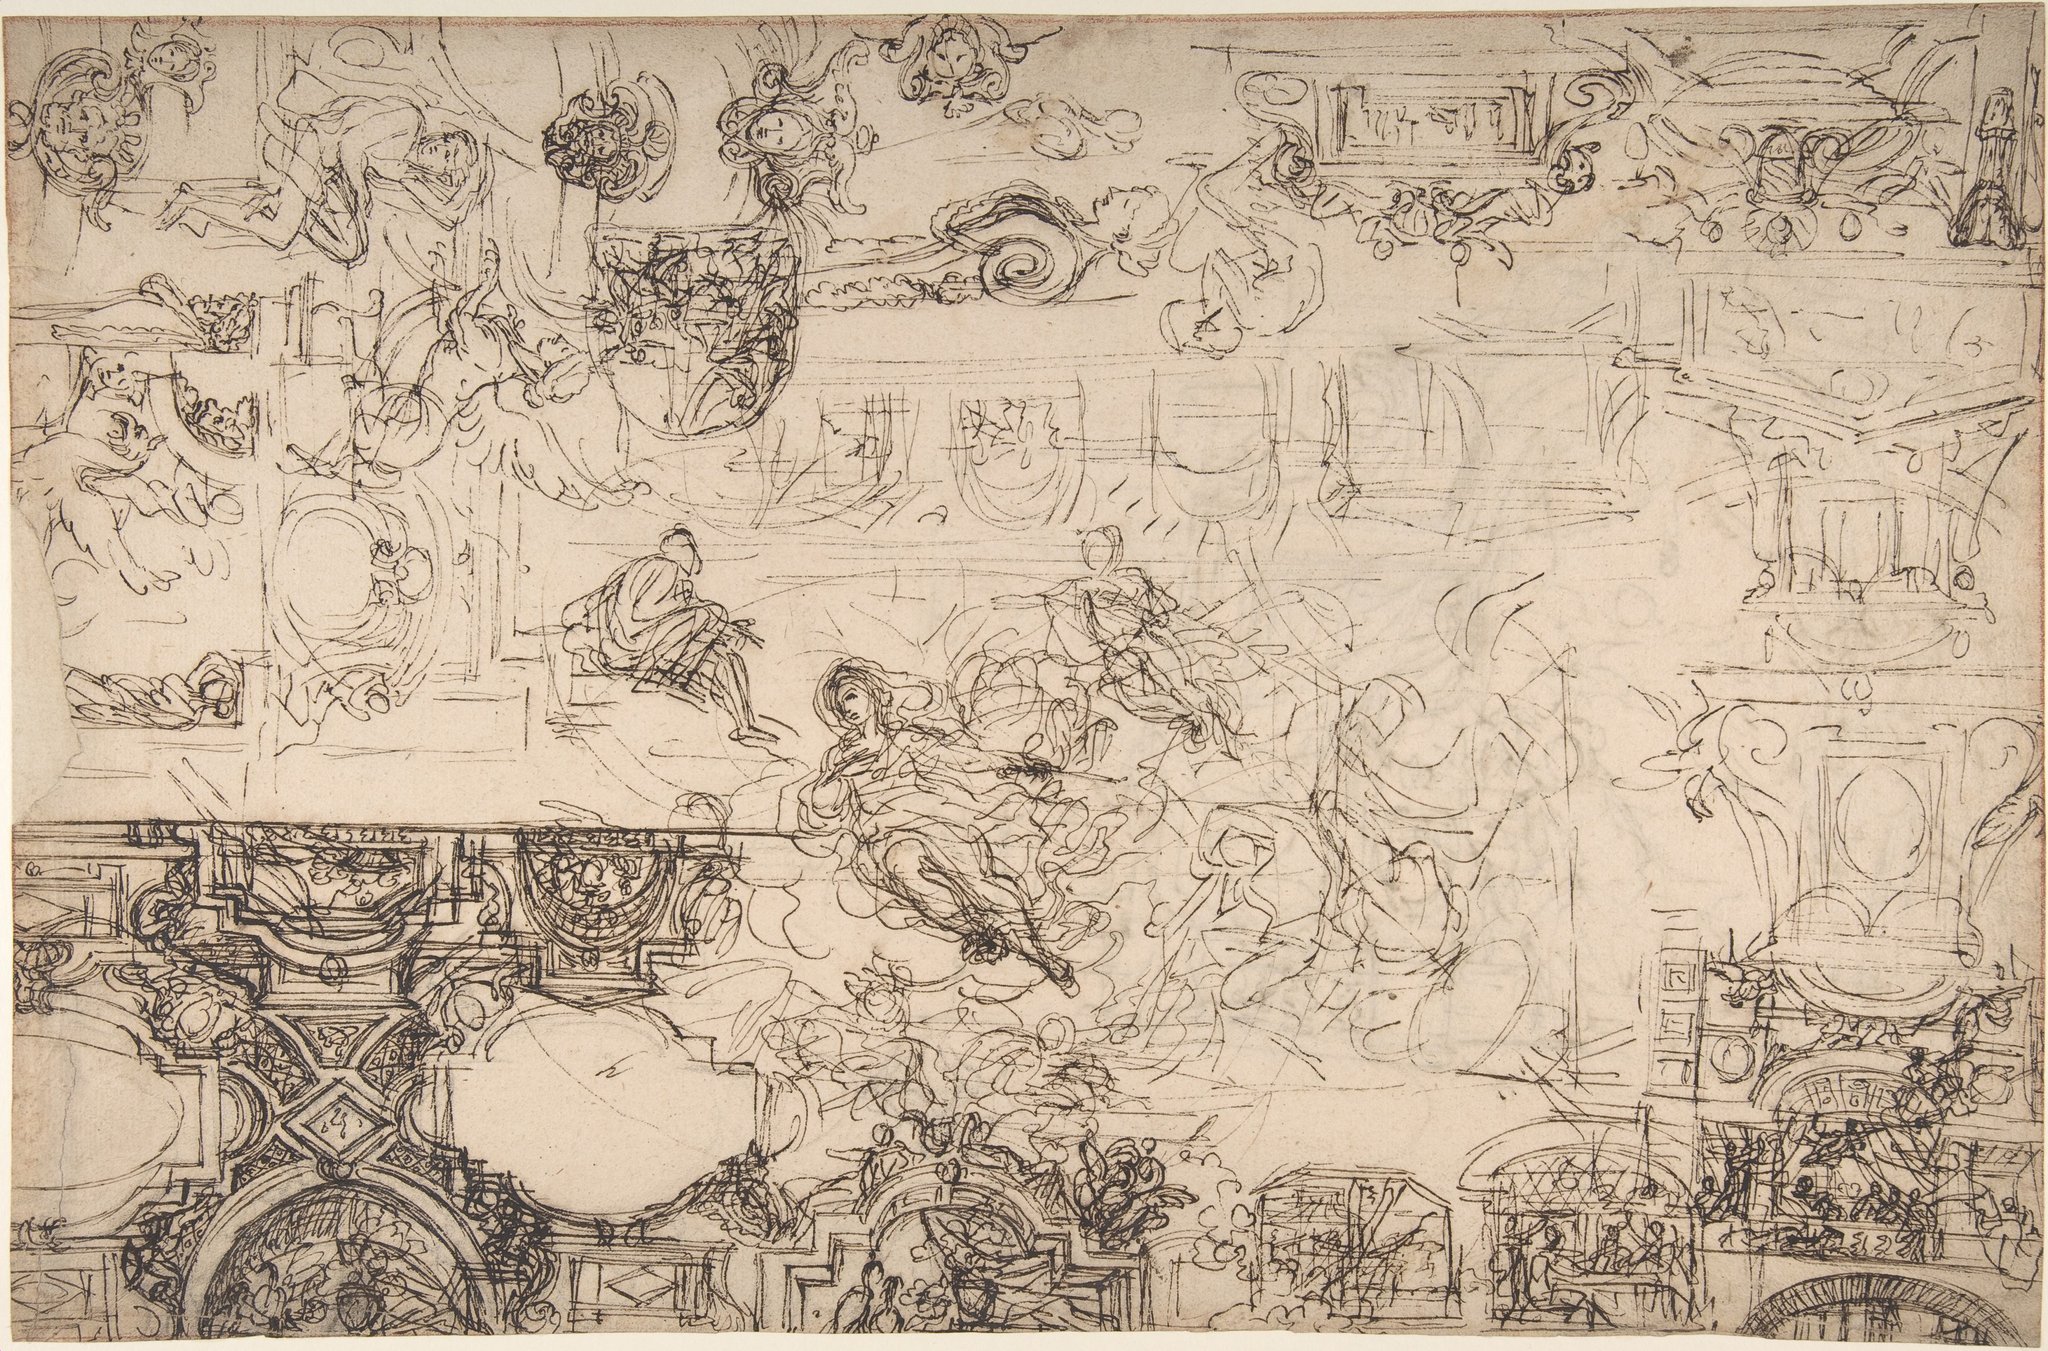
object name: drawing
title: Studies for a Ceiling (recto and verso)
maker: michel corneille the younger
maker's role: artist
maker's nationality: french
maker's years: 1642-1708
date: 1660-1680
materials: ink, drawing material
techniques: pen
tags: architecture,ceilings